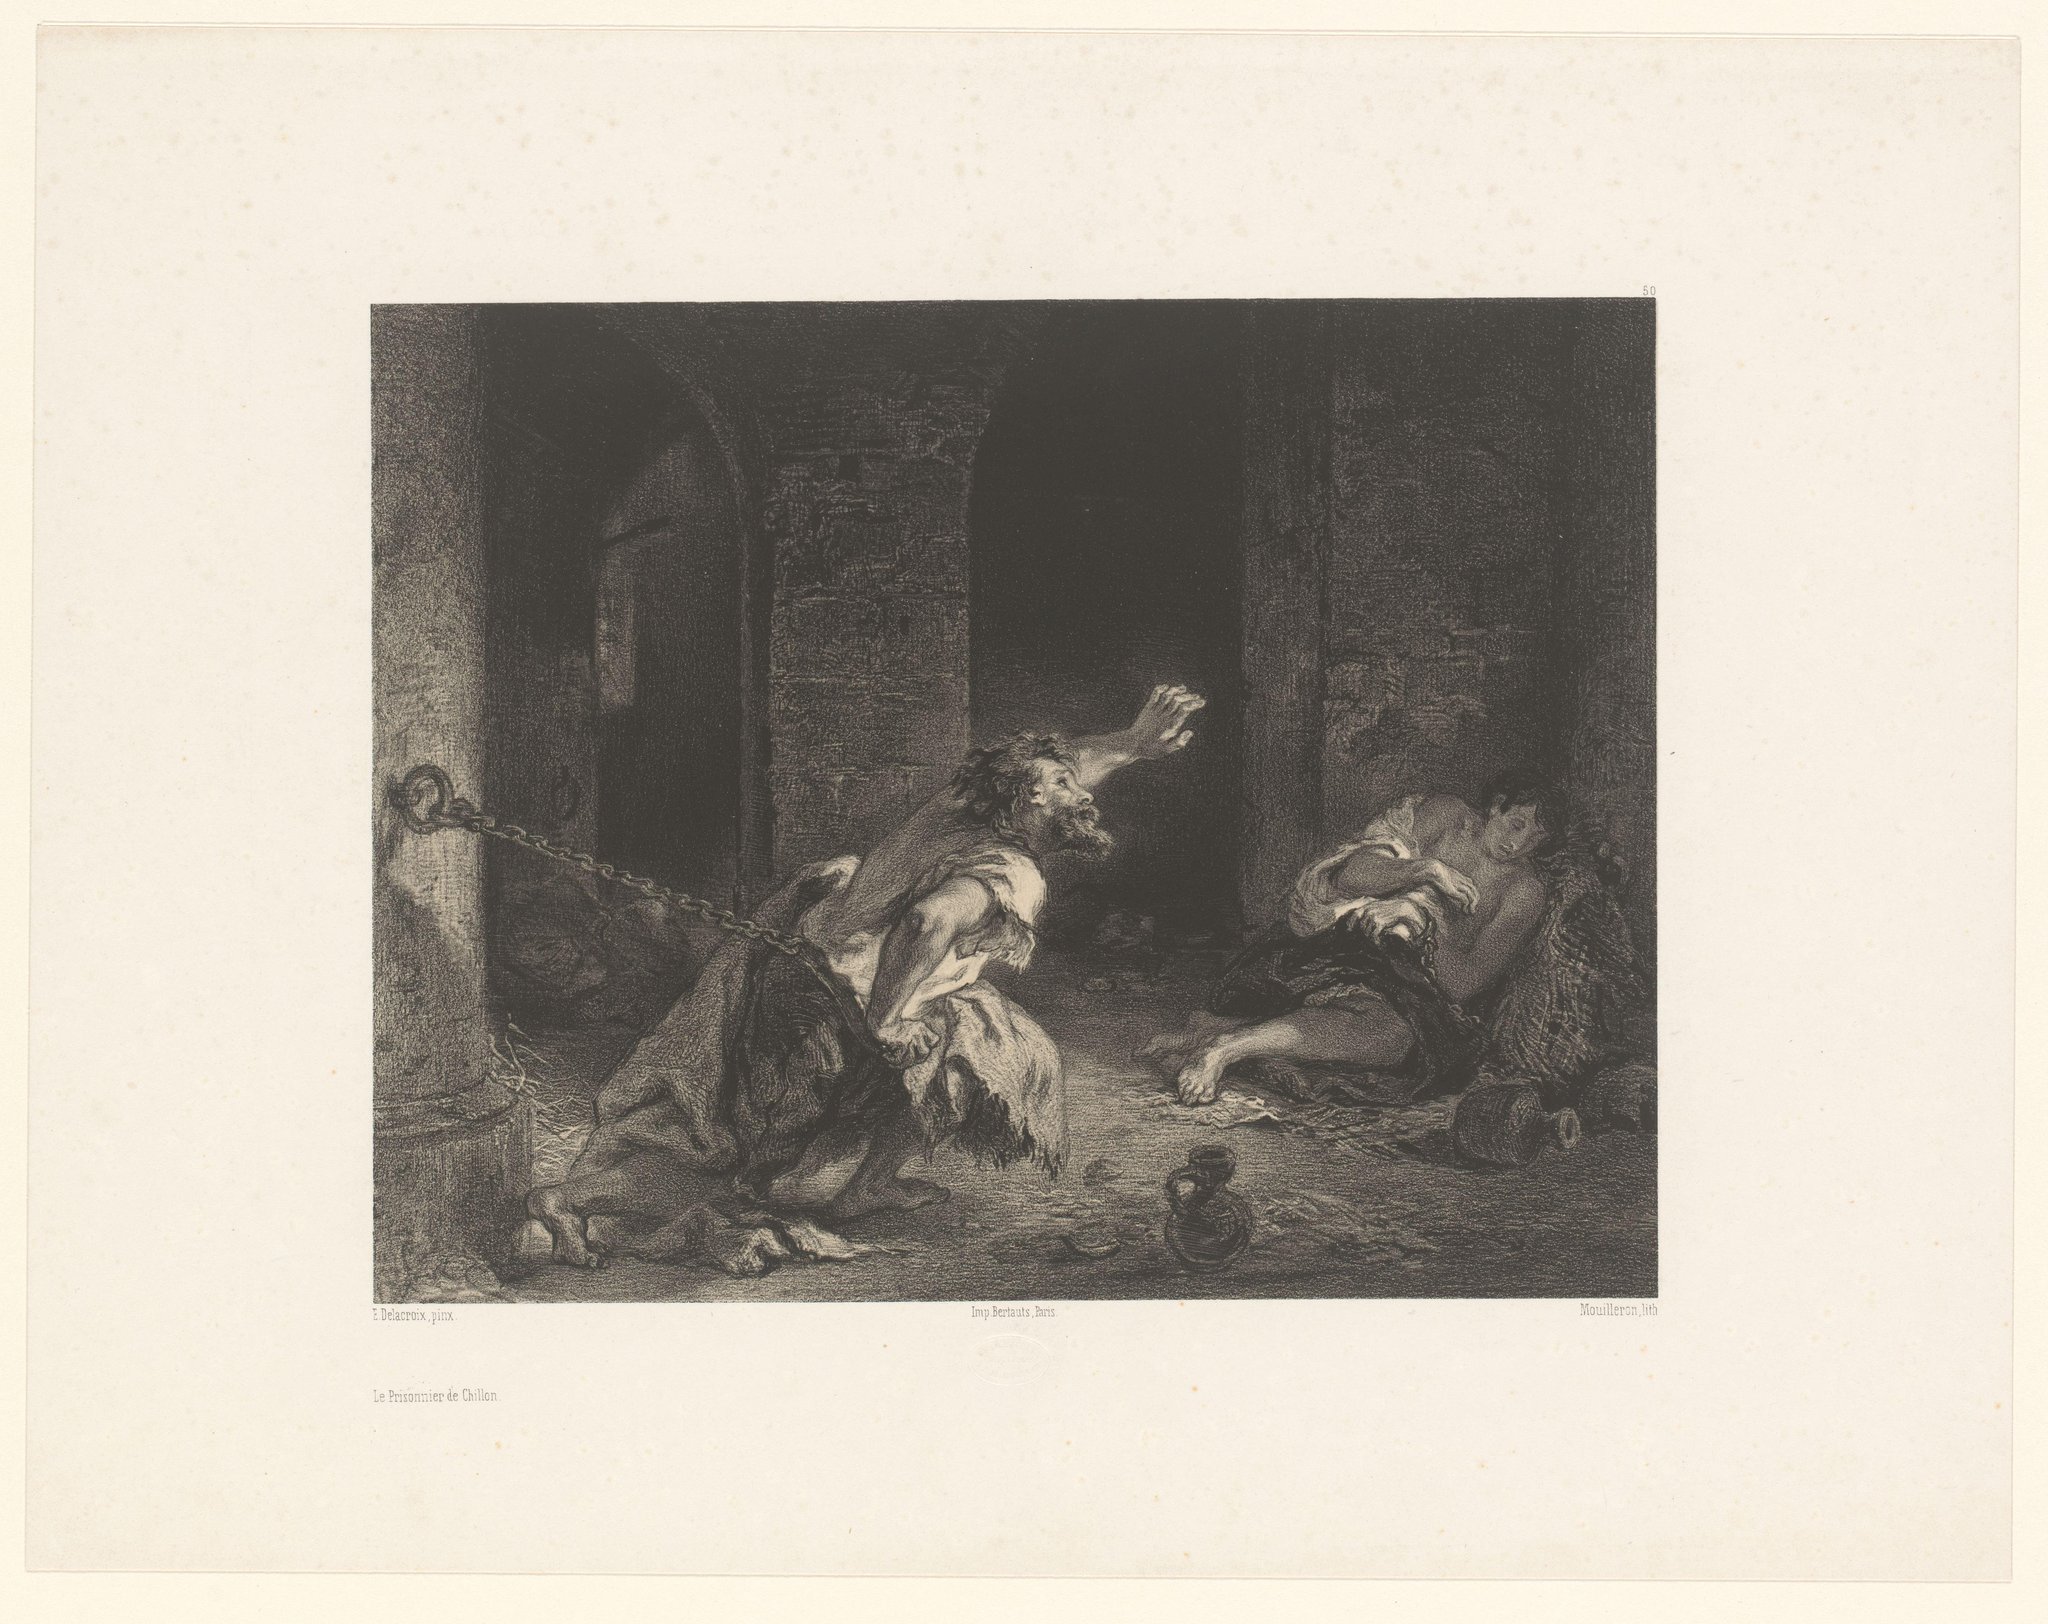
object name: print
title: Le prisonnier de Chillon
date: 1848-1862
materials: paper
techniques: lithograph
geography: paris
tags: prisoner; in fetters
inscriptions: check stamp: Lugt 36a, collector's mark: Lugt 2228